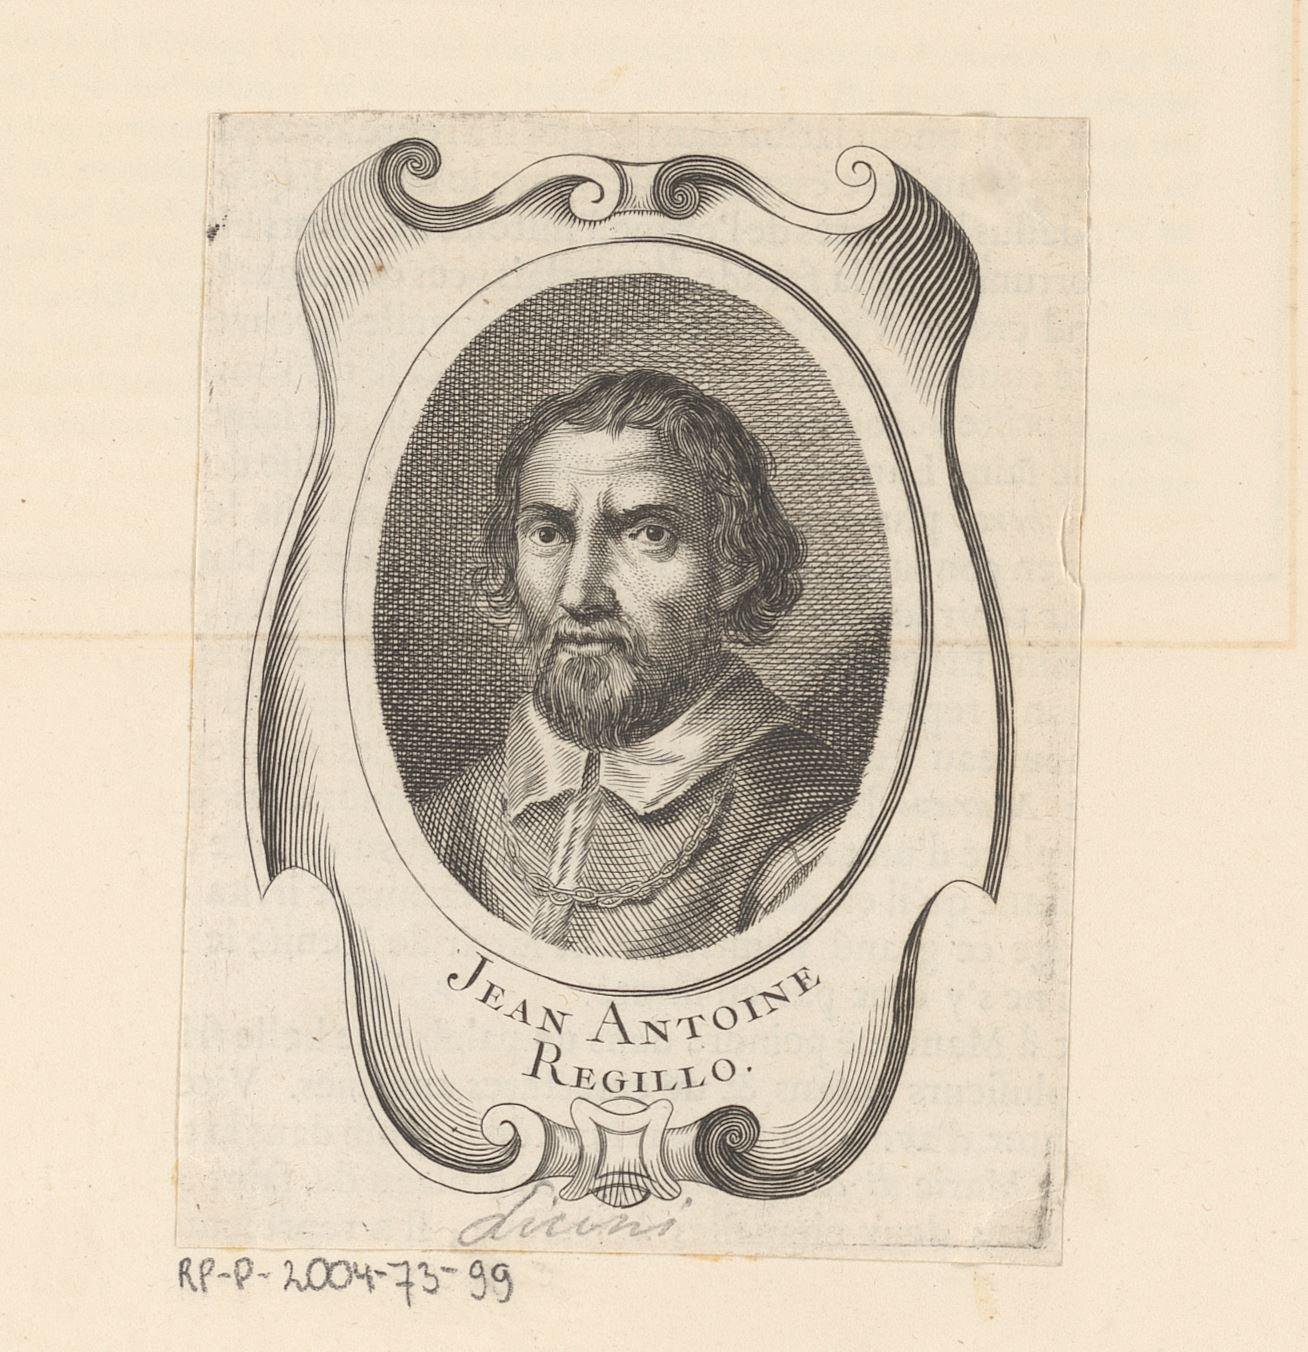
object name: book illustration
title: Portret van Pordenone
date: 1745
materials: paper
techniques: engraving, letterpress printing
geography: paris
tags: painter, print maker, draughtsman, pordenone, historical persons, portrait, self-portrait of painter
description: Prent uit: Dézallier d'Argenville, Antoine Joseph. Abrégé de la vie des plus fameux peintres. 4 dln. Parijs: De Bure l'aîné, 1745, dl. 1, p. 151. De samensteller heeft deze prent in het album geplakt als illustratie bij: Pilkington, Matthew en Johann Heinrich Füssli. A dictionary of painters, from the revival of the art to the present period. 4 dln. Londen: John Crowder, 1805, dl. 2, p. 295.